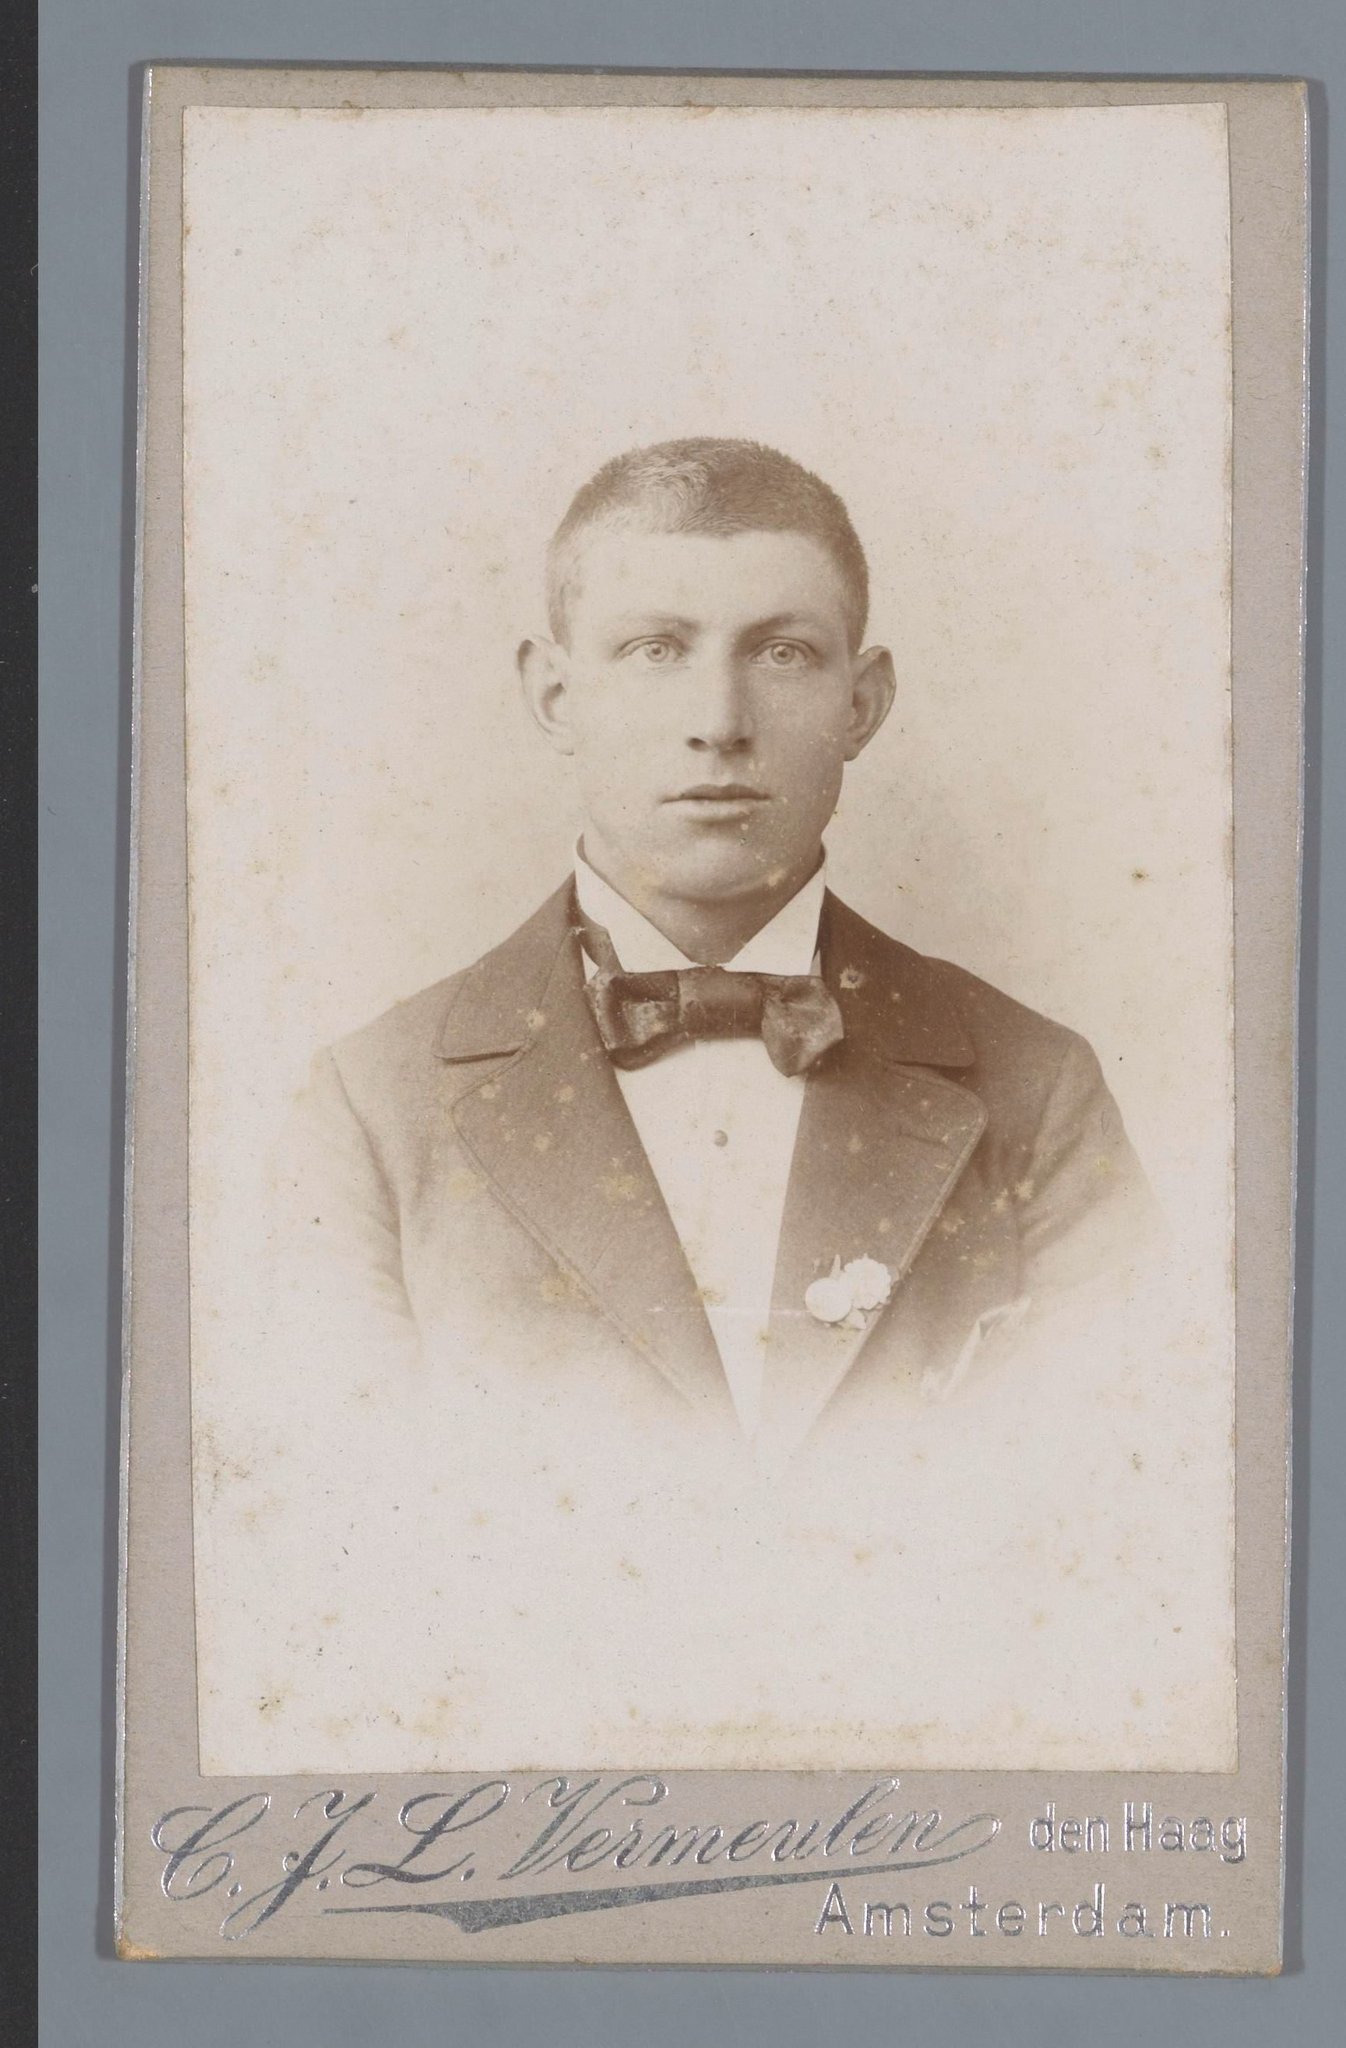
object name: photograph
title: Portret van een onbekende man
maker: cornelis johannes lodewicus vermeulen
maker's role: fotograaf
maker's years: 1861-1936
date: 1888-1915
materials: cardboard, paper, photographic support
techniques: collodion silver print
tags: adult man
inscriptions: name: ‘C.J.L. Vermeulen den Haag Amsterdam.’, inscription: ‘C.J.L. Vermeulen Heerenstraat 6, Heiligenweg hoek Singel Amsterdam Telephoon No. 2339 en 2340. Toussaintkade 11. den Haag. Intercommunal Telephoon: 774.’